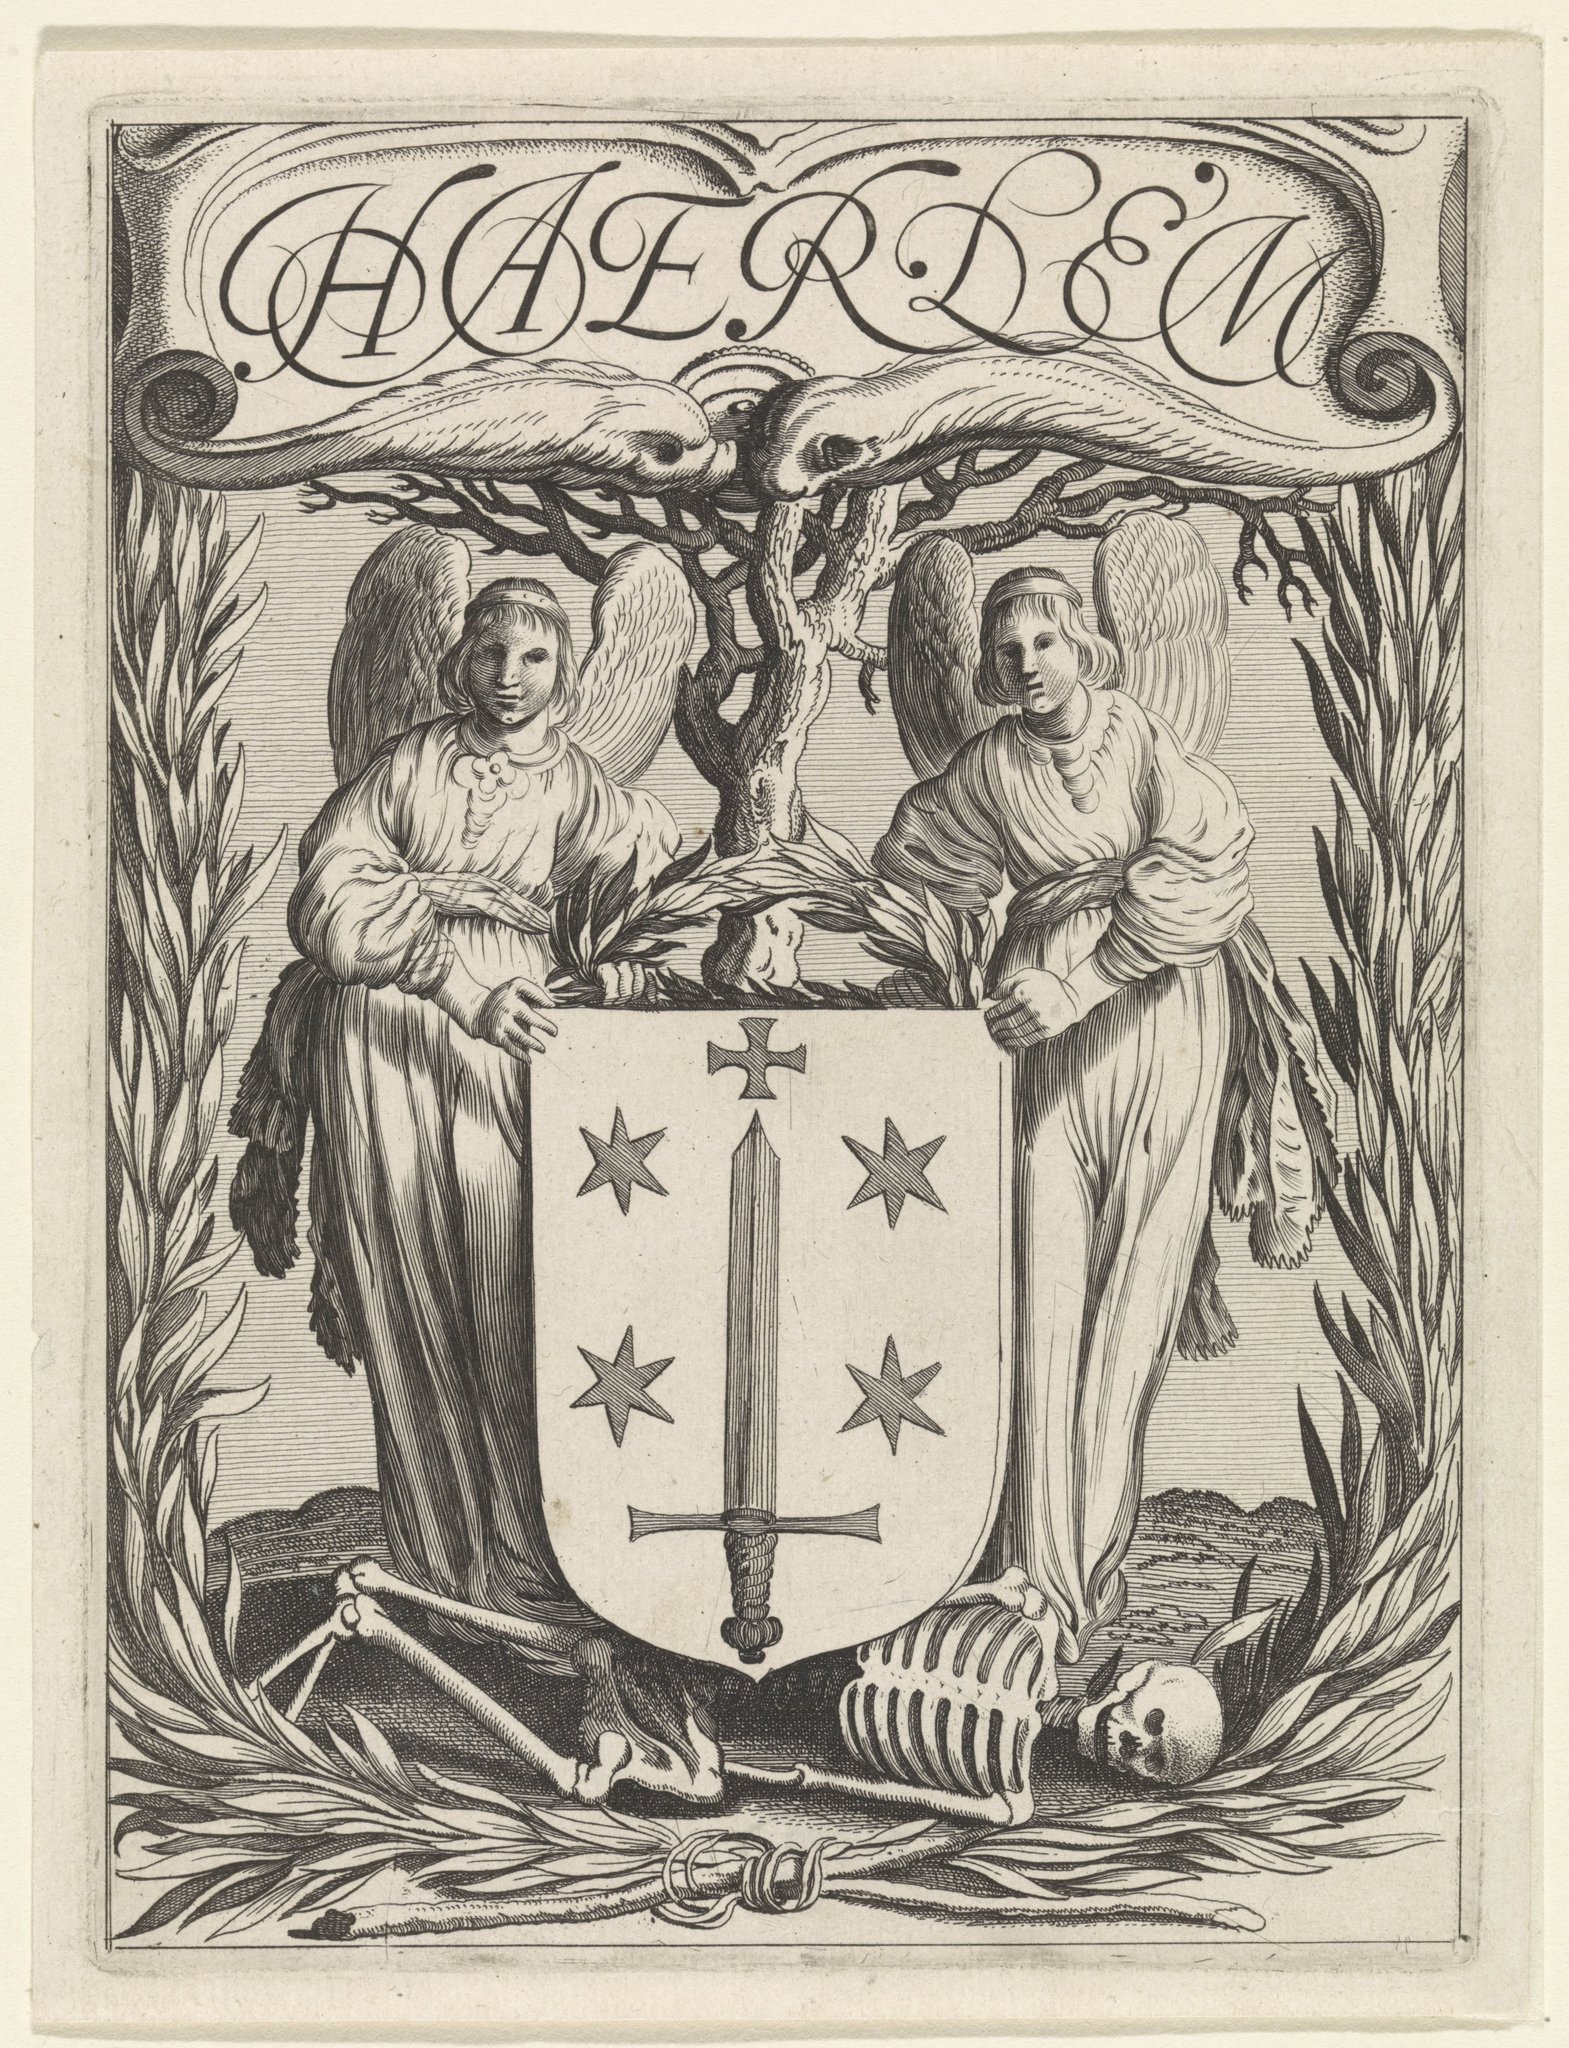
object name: book illustration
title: Haerlem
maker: jan van de velde (ii)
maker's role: draughtsman, painter, print maker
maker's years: 1593-1641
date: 1628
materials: paper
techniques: engraving, etching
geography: haarlem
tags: coat of arms (as symbol of the state, etc.) (+ city; municipal), (human) skeleton, angels, haarlem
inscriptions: collector's mark: Lugt 964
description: Prent ook gebruikt in: Ampzing, Samuel. Beschryvinge ende lof der stad Haerlem in Holland […]. Haarlem: Adriaen Roman (I), 1628.